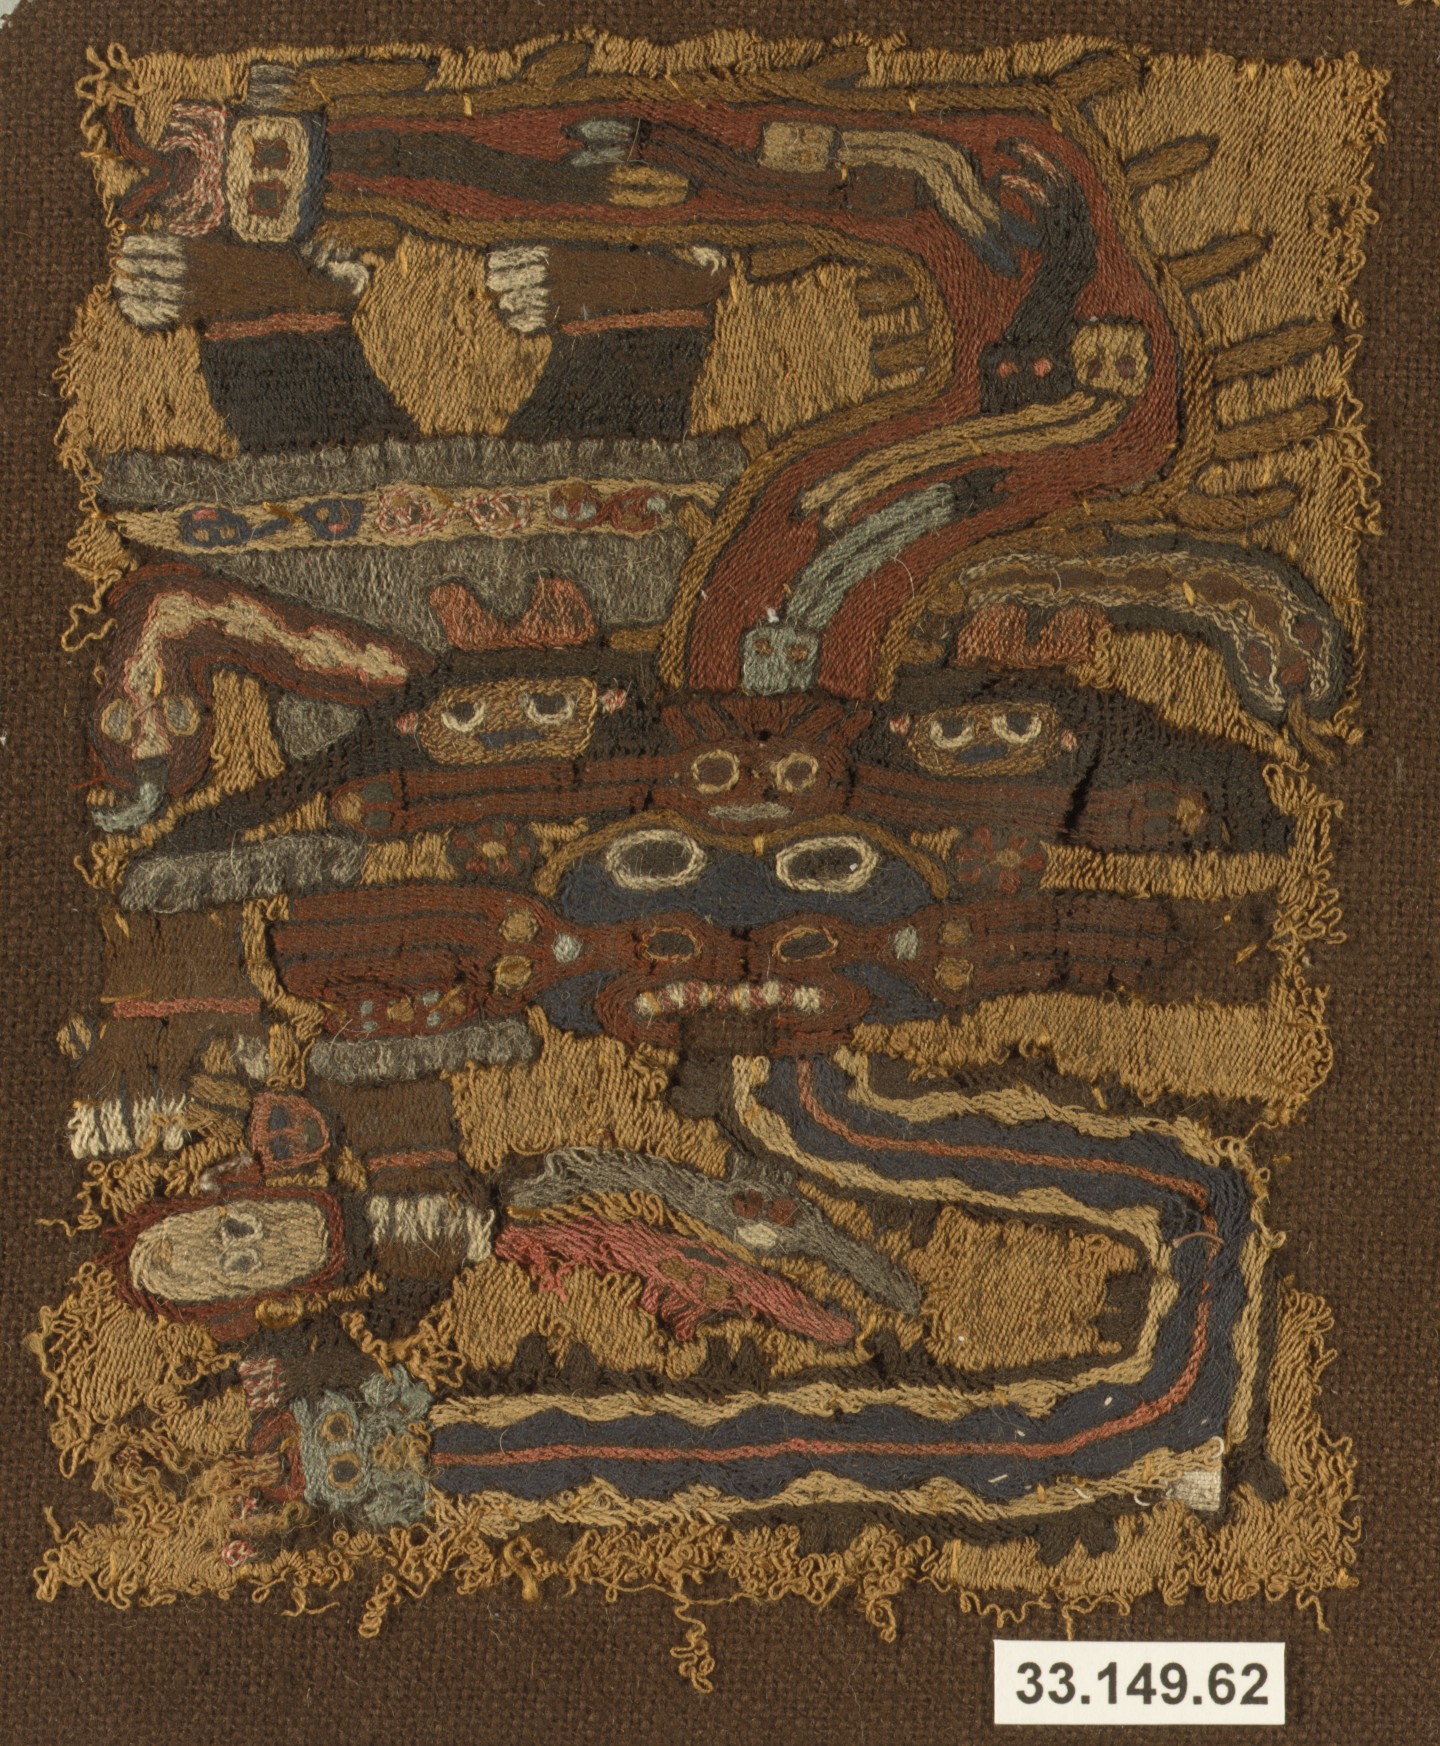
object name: mantle fragment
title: Embroidered Mantle Fragment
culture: paracas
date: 300-101 BCE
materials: animal fiber, cotton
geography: peru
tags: heads,serpents